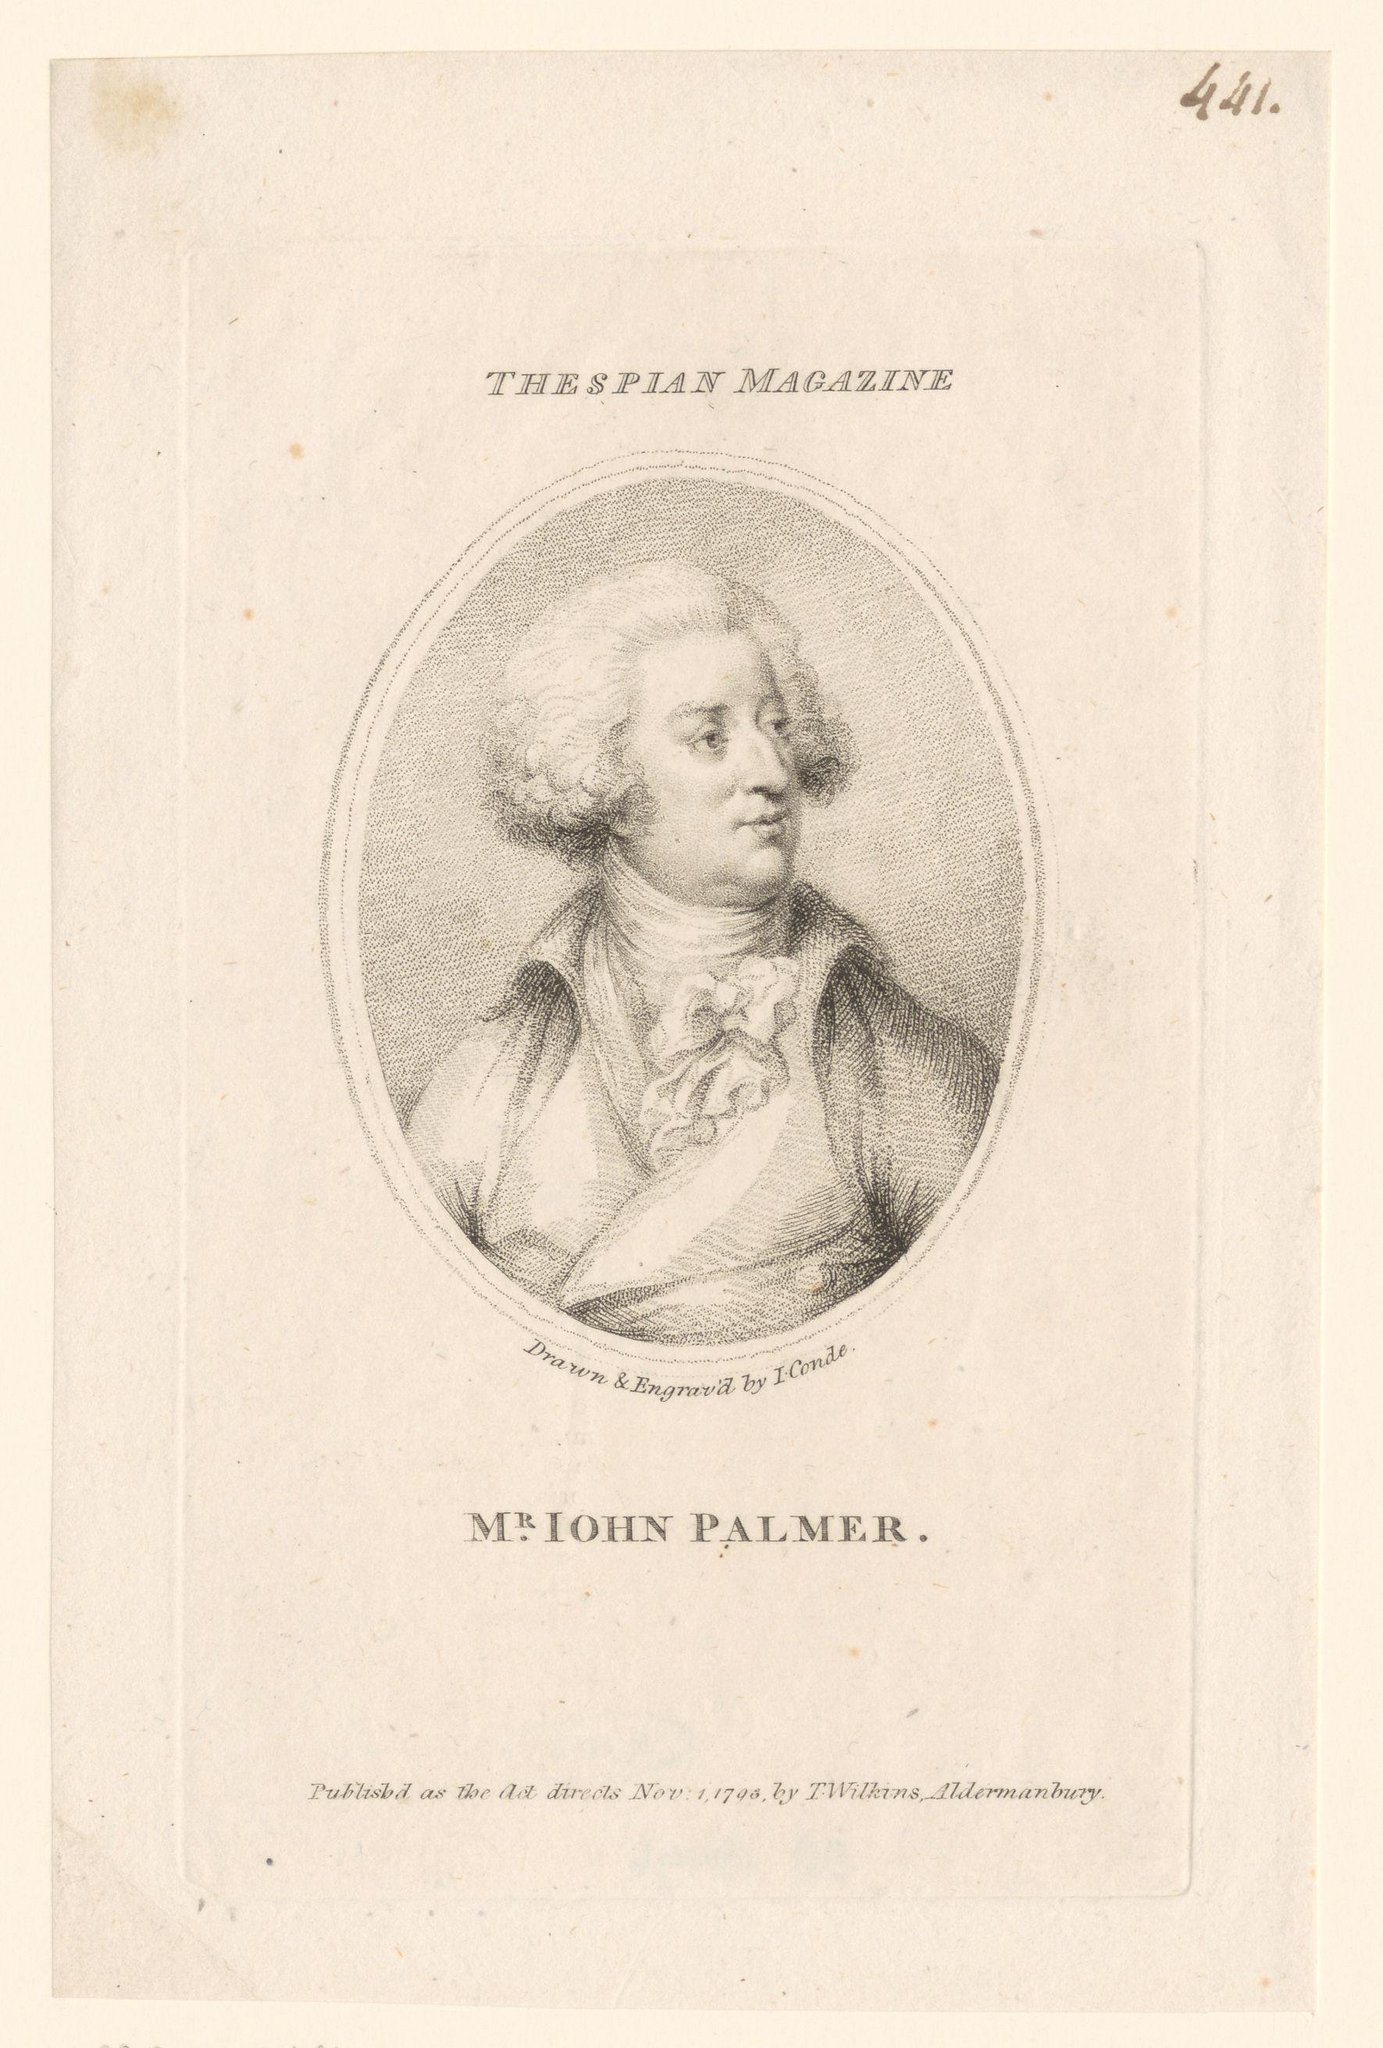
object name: print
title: Portret van John Palmer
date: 1793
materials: paper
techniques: stippling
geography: aldermanbury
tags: london, historical persons, portrait of actor, actress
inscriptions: collector's mark: Lugt 2228, number: ‘441’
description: Prent gebruikt in: Thespian Magazine (1793).